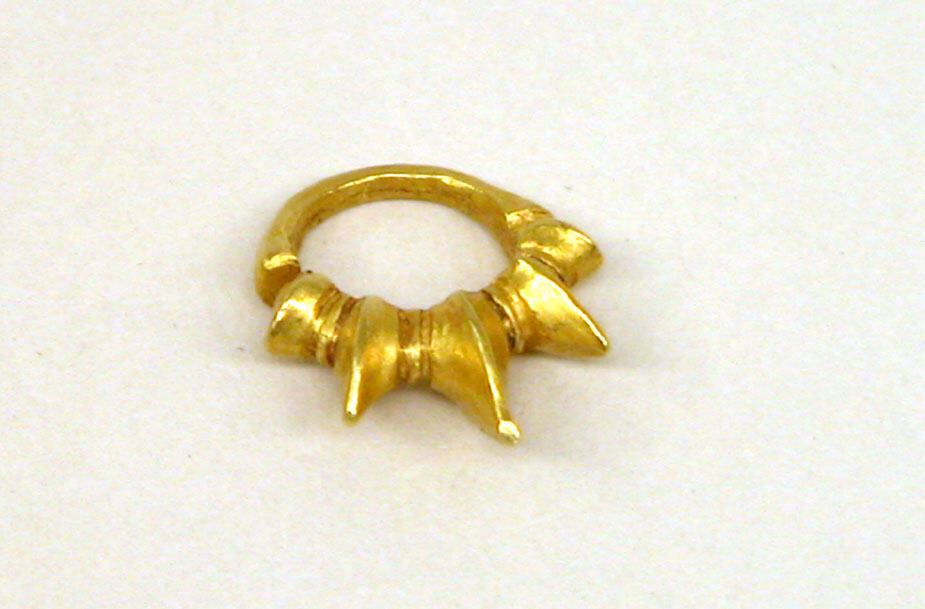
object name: ear ornament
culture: indonesian, javanese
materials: gold